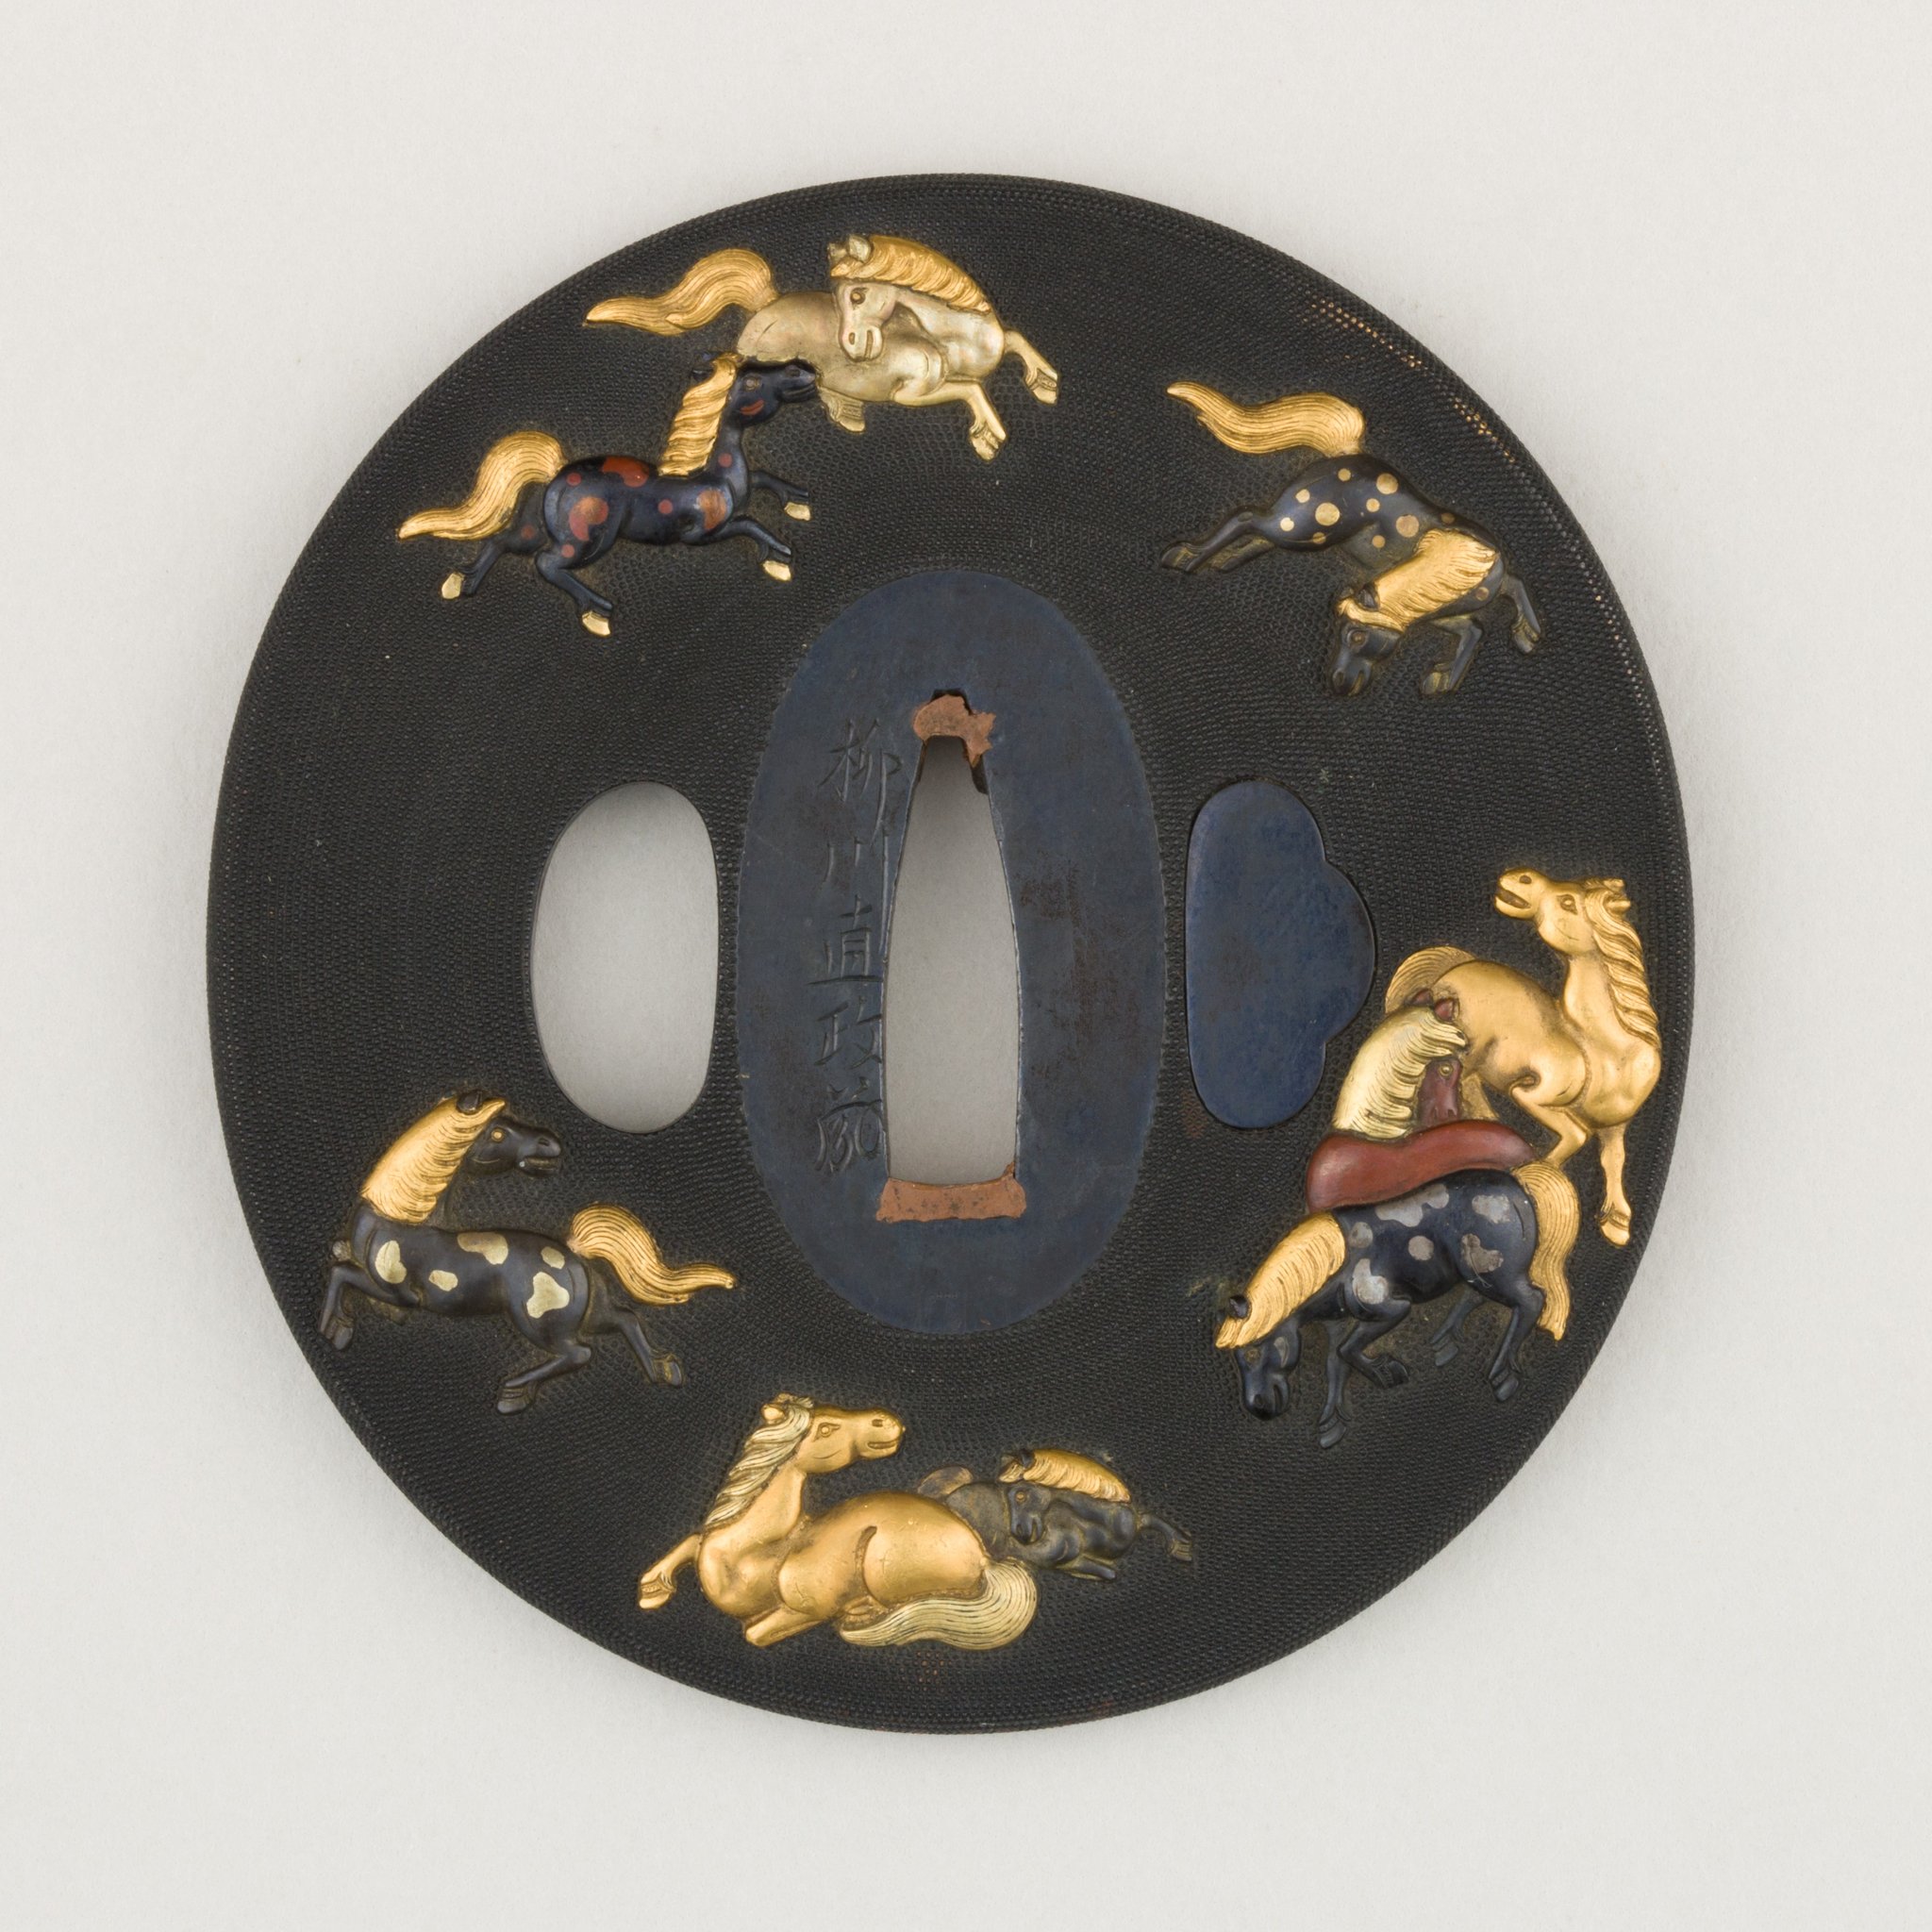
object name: sword guard tsuba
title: Sword Guard (Tsuba)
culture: japanese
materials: bronze, copper, gold alloy, gold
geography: japan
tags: horses